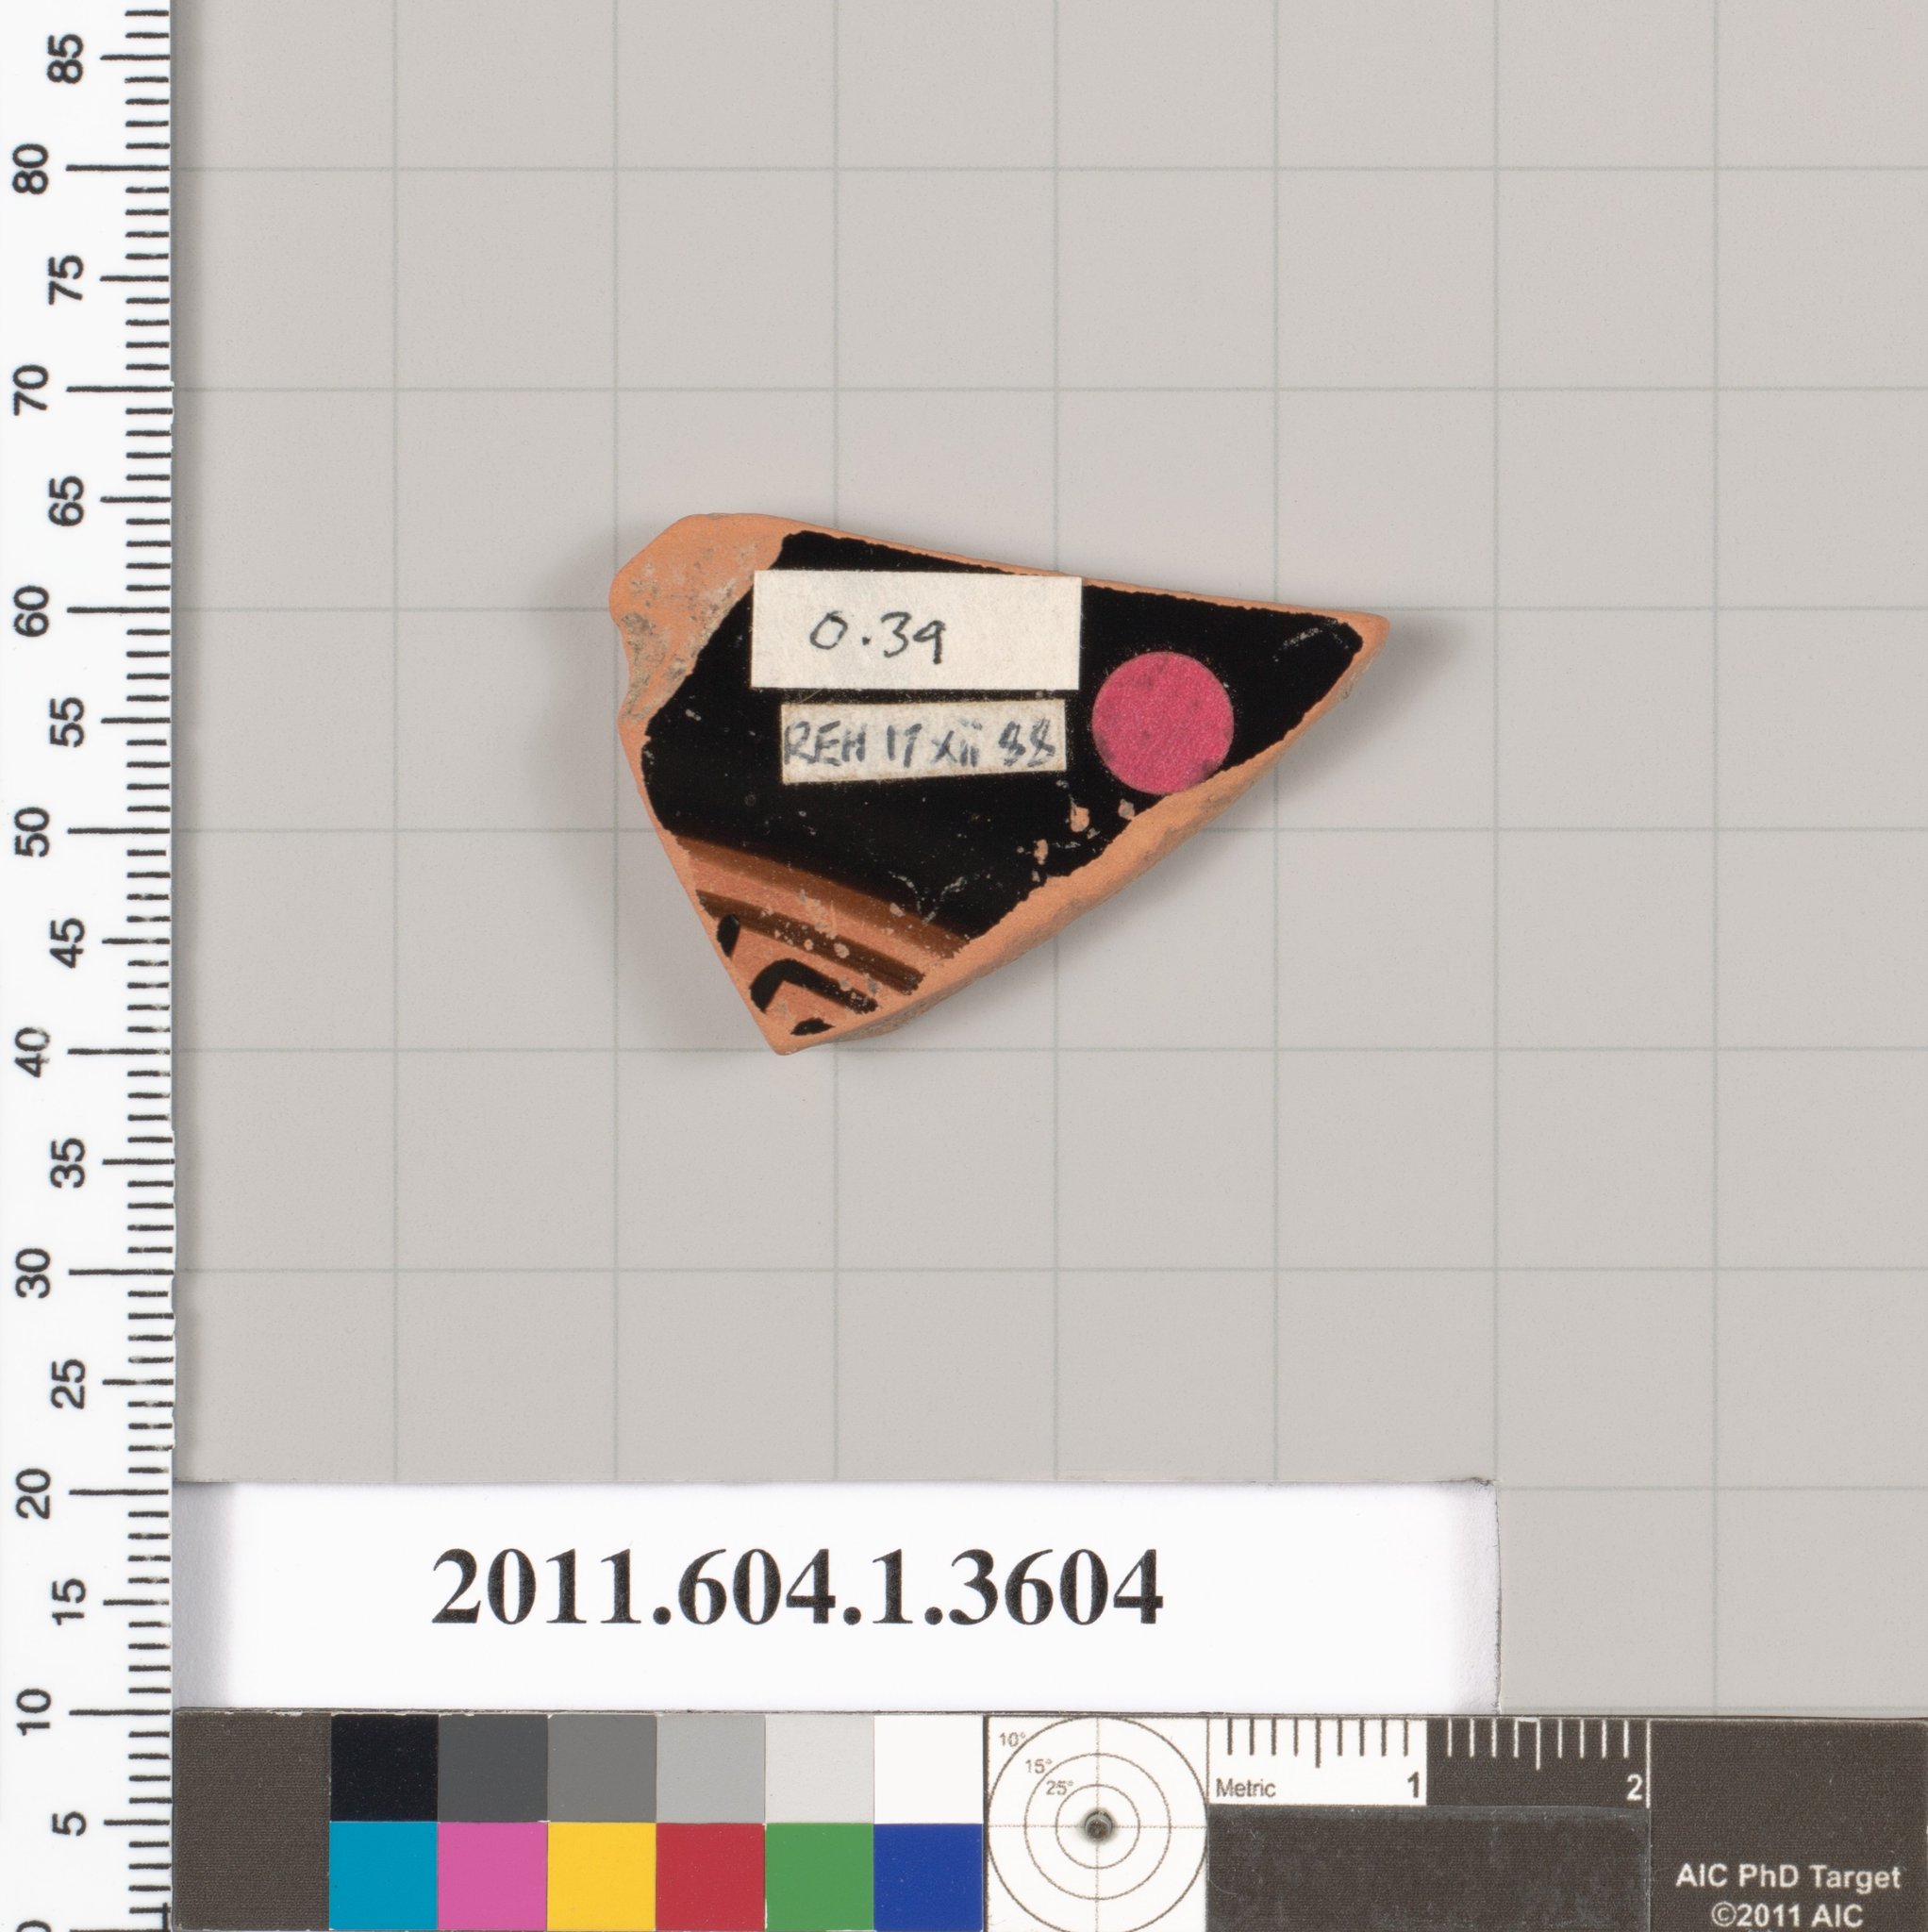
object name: kylix fragment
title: Terracotta fragment of a kylix (drinking cup)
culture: greek, attic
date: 500-470 BCE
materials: terracotta